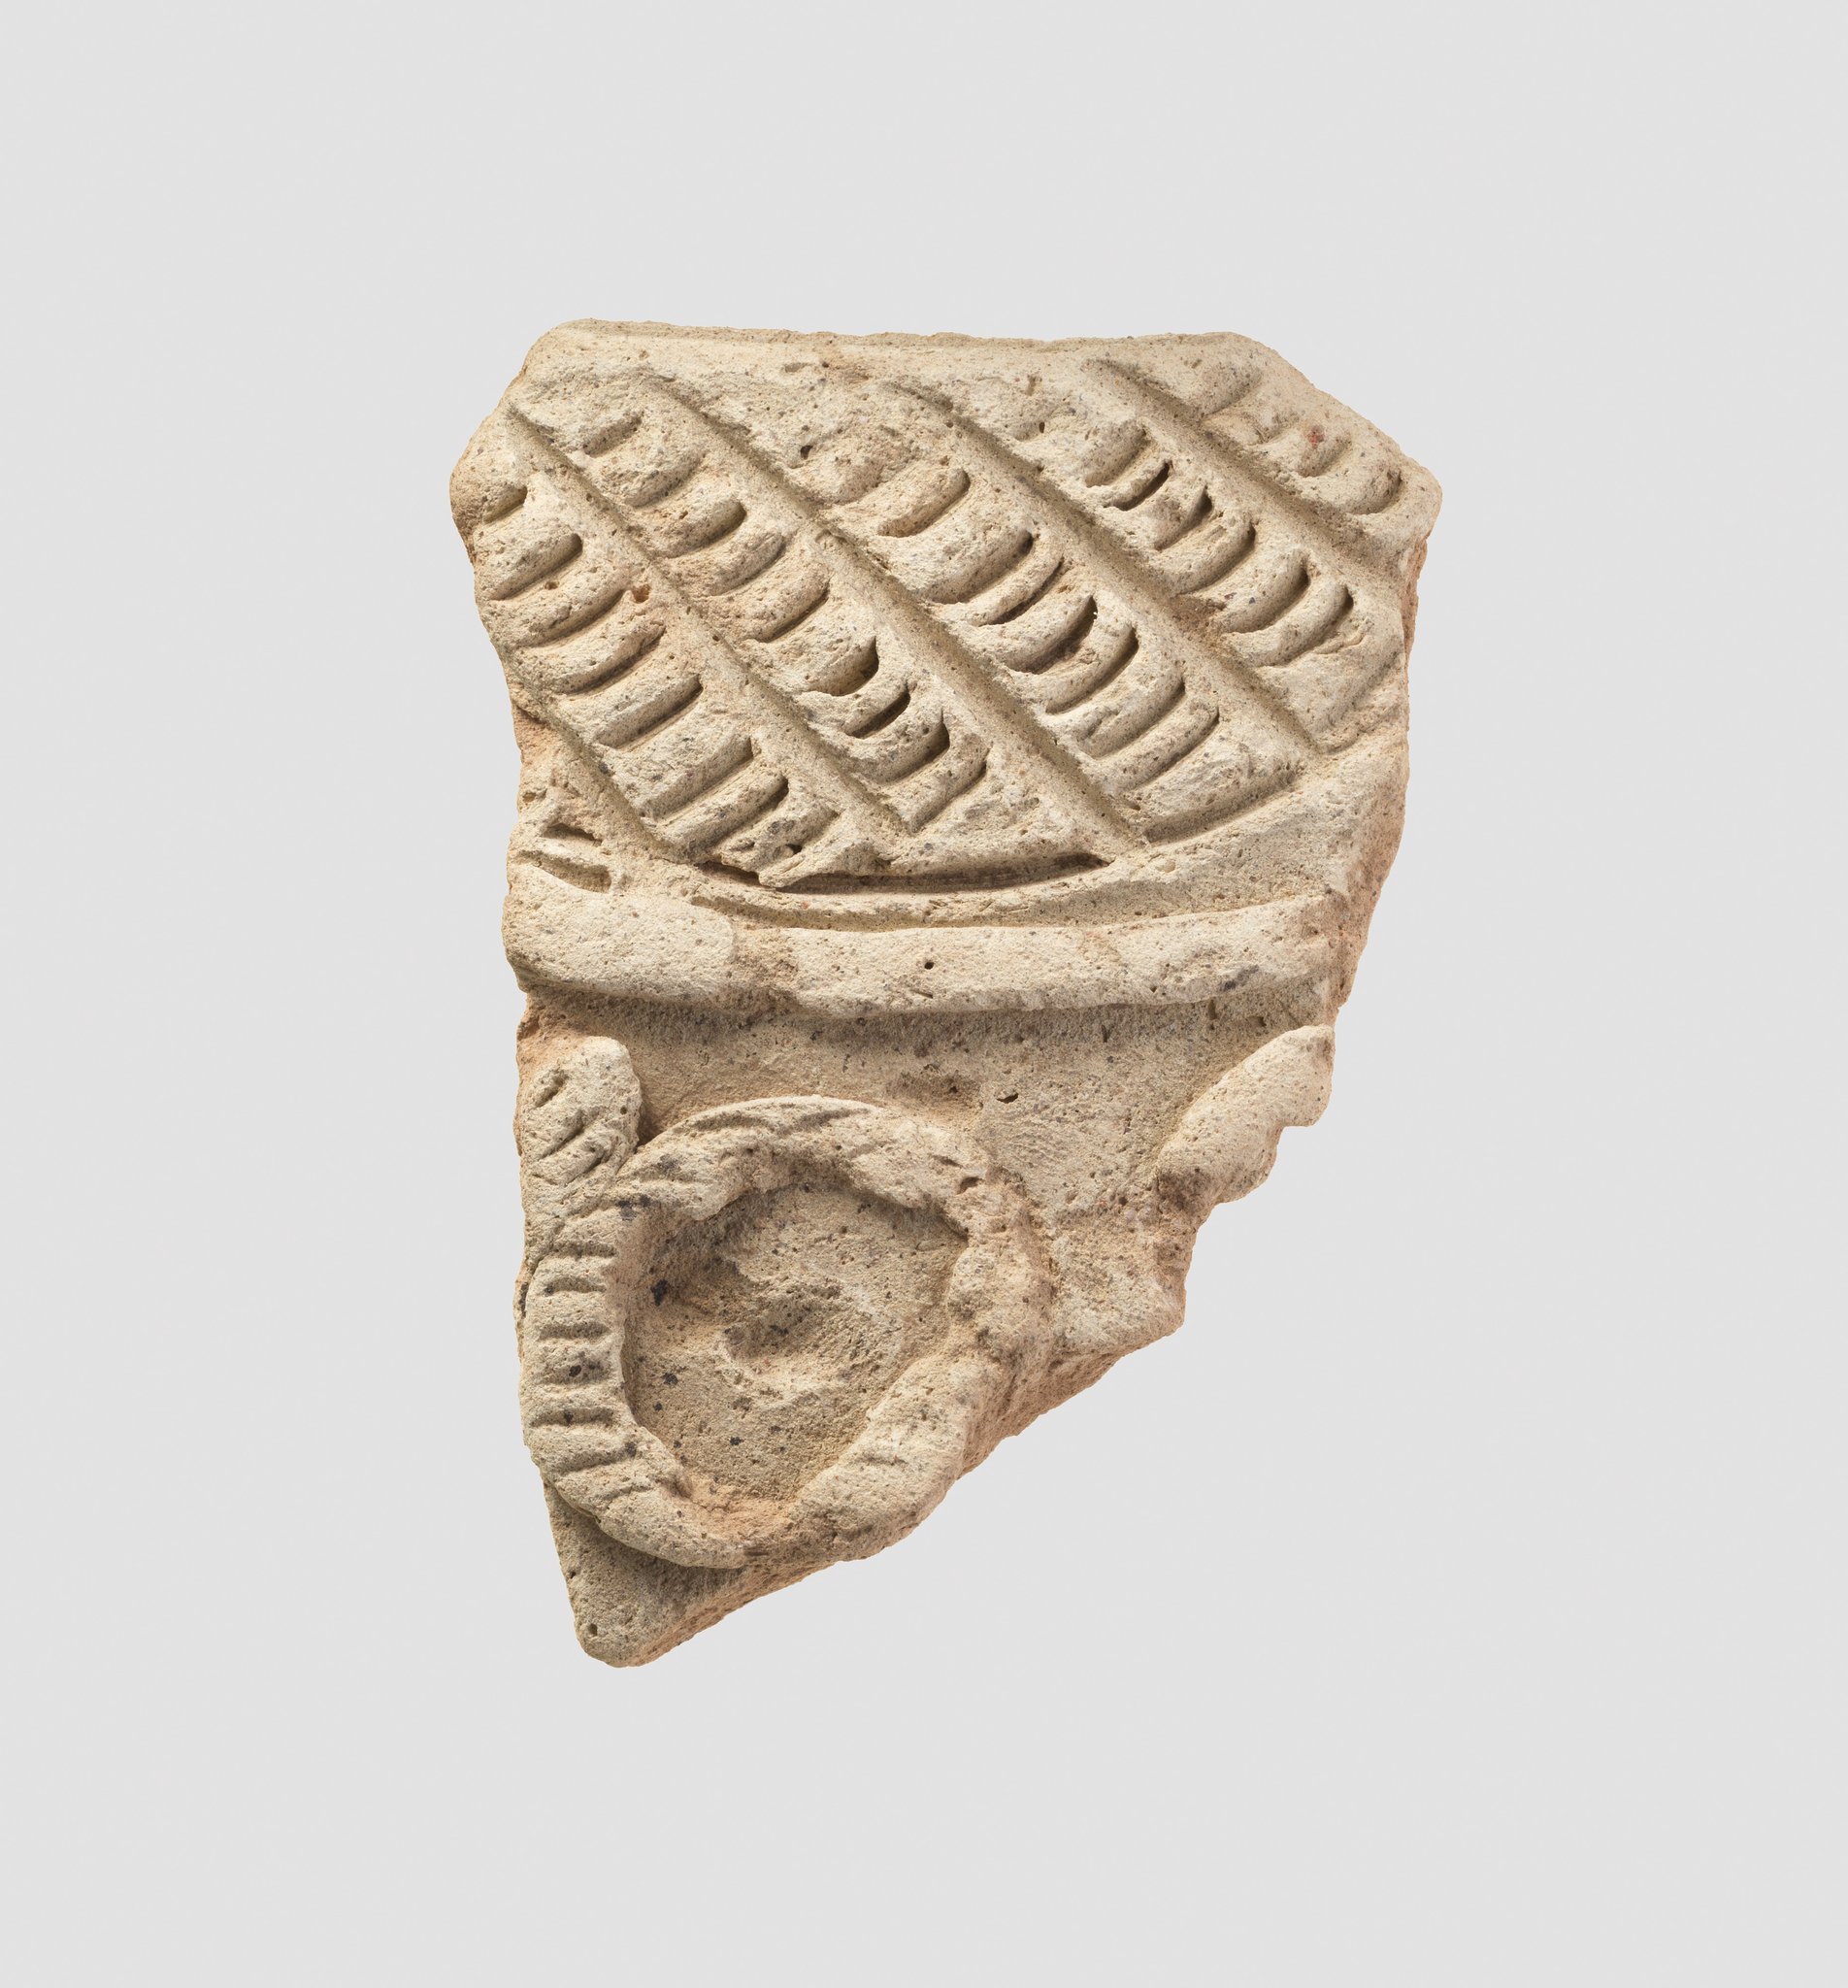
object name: sherd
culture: sasanian or islamic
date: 501-800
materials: ceramic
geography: mesopotamia